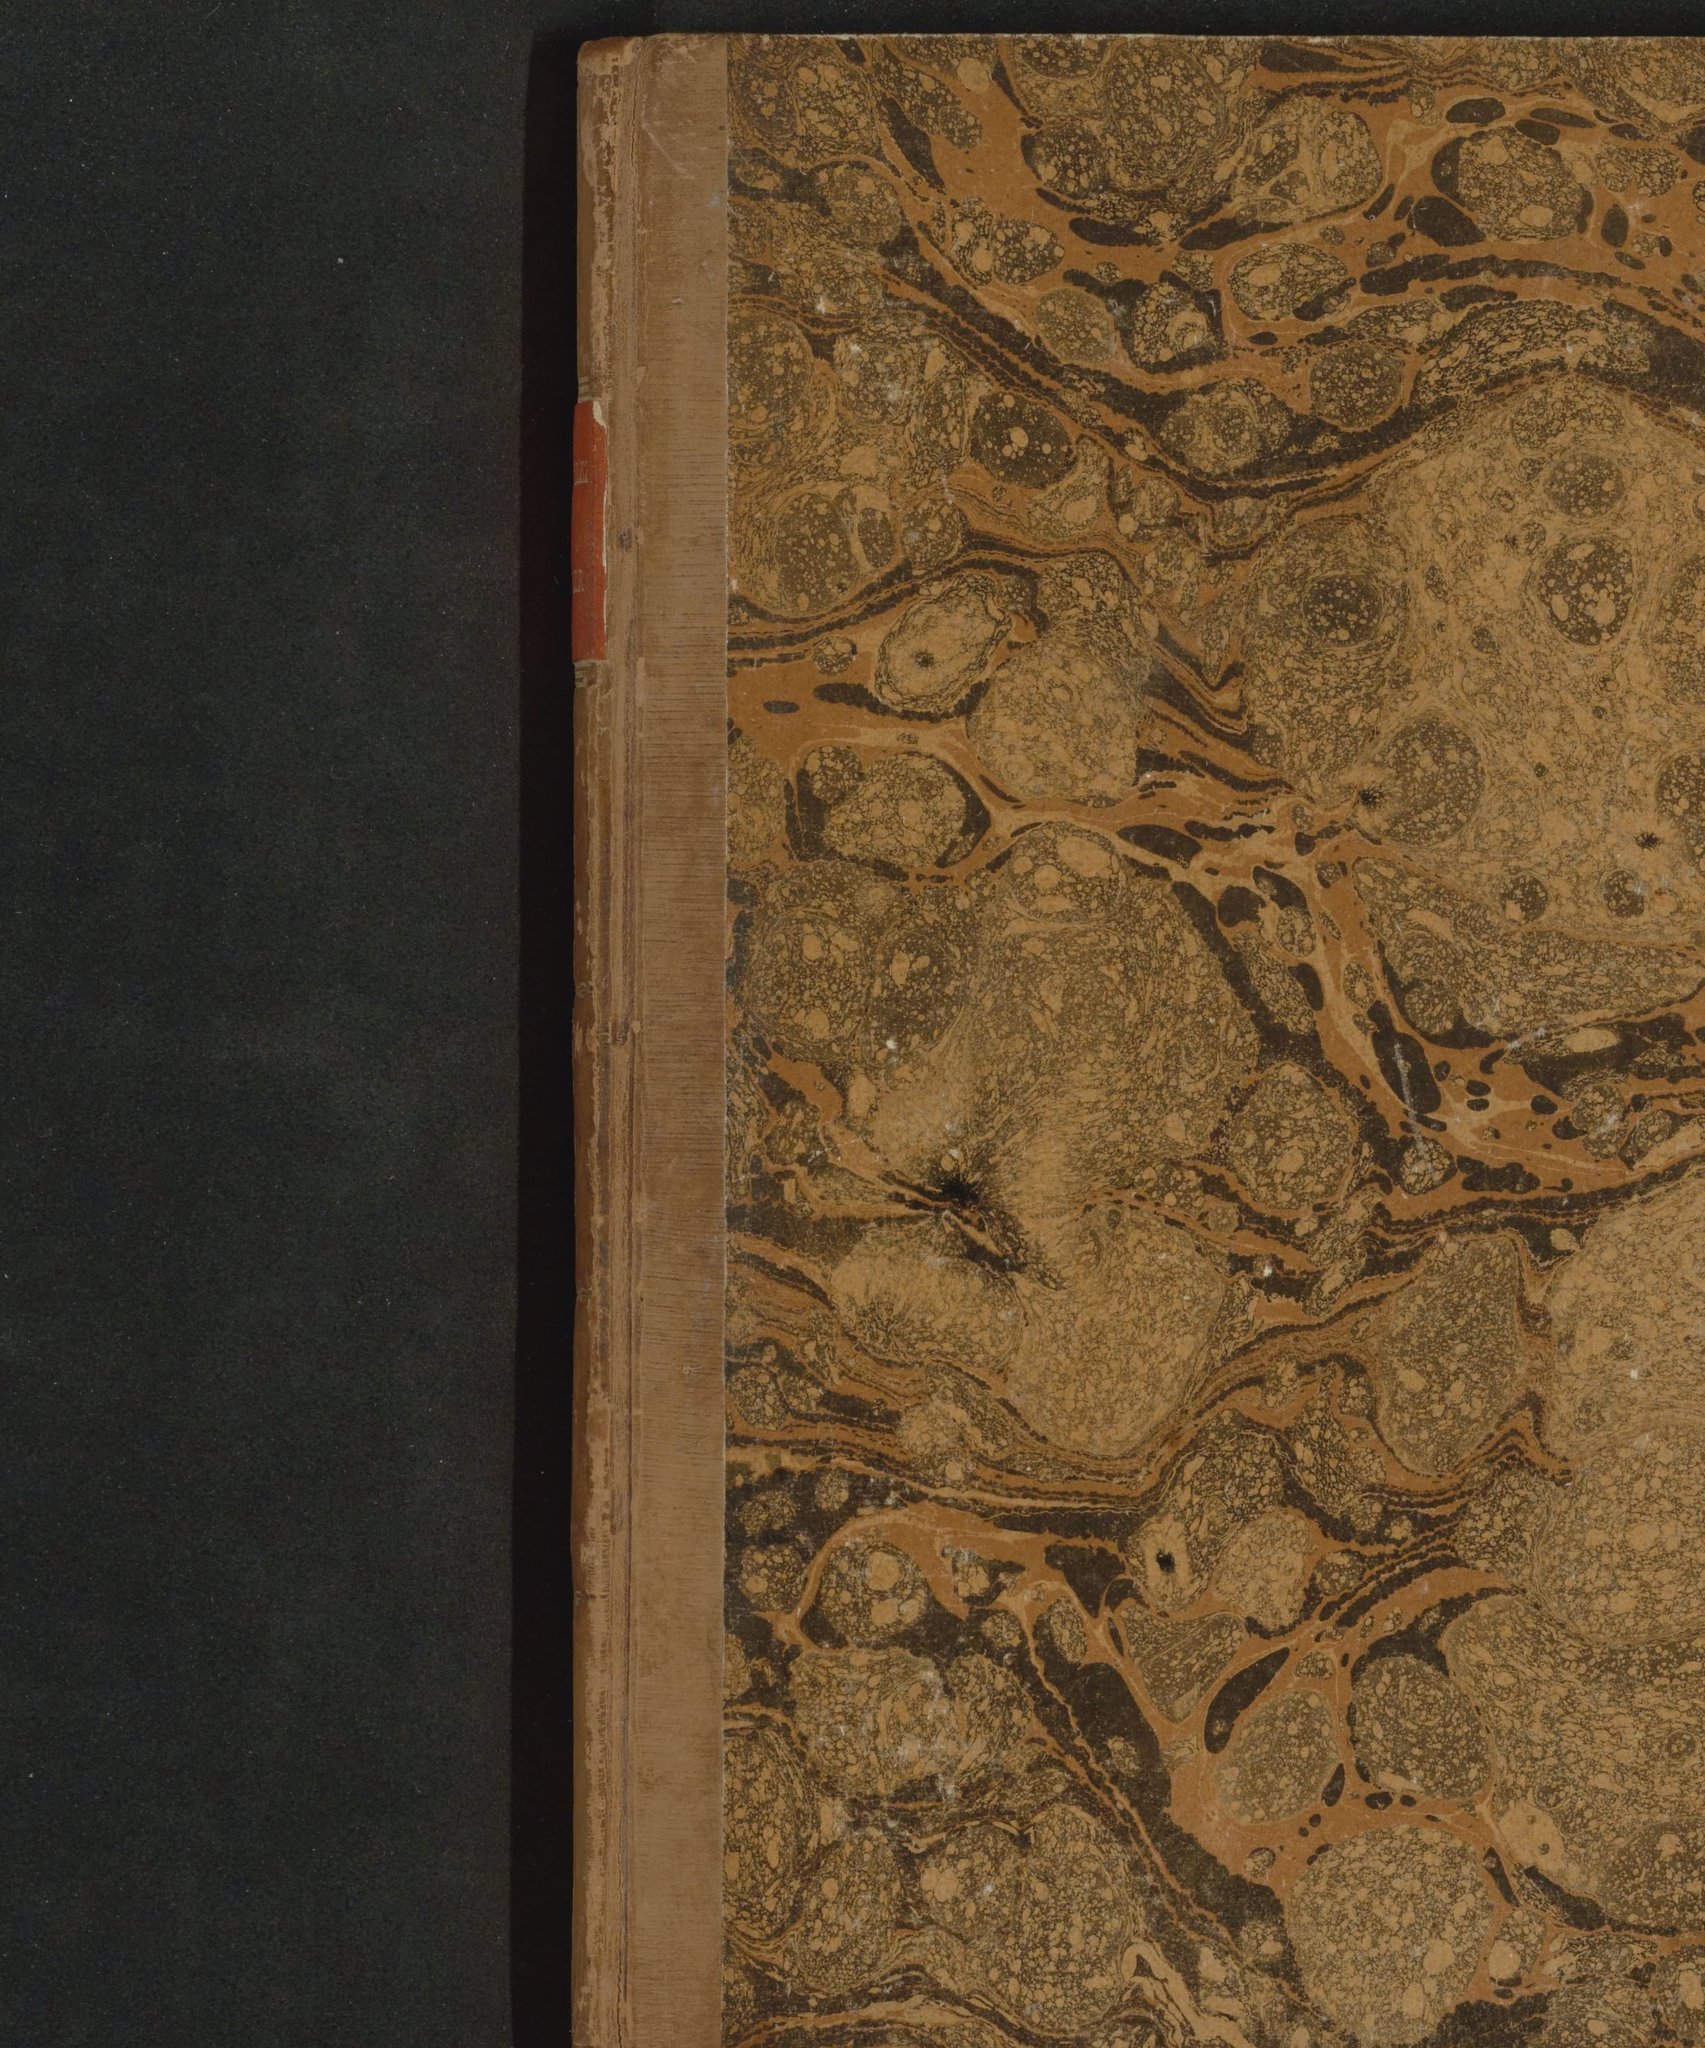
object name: sketchbook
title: Schetsboek met 94 bladen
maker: jonkvrouw elisabeth kemper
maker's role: draughtsman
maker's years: 1799-1871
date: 1815-1852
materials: cardboard, chalk, ink, leather, paper, pencil, watercolor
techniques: brush, pen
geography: rheden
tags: female persons from classical history (+ belonging to greek history), container of stone: stone vase, mathematical perspective, historical persons (portraits and scenes from the life)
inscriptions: date: ‘1816’, name: ‘ELISABET KEMPER’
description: Schetsboek bestaande uit 94 bladen en 11 losse tekeningen met voornamelijk figuren in klassieke dracht, mythologische en bijbelse figuren, Griekse vazen, urnen en altaren, perspectiefoefeningen en portretten. Deels getekend tijdens de lessen van D.G.P. Humbert de Superville, onder andere naar Rafaël.